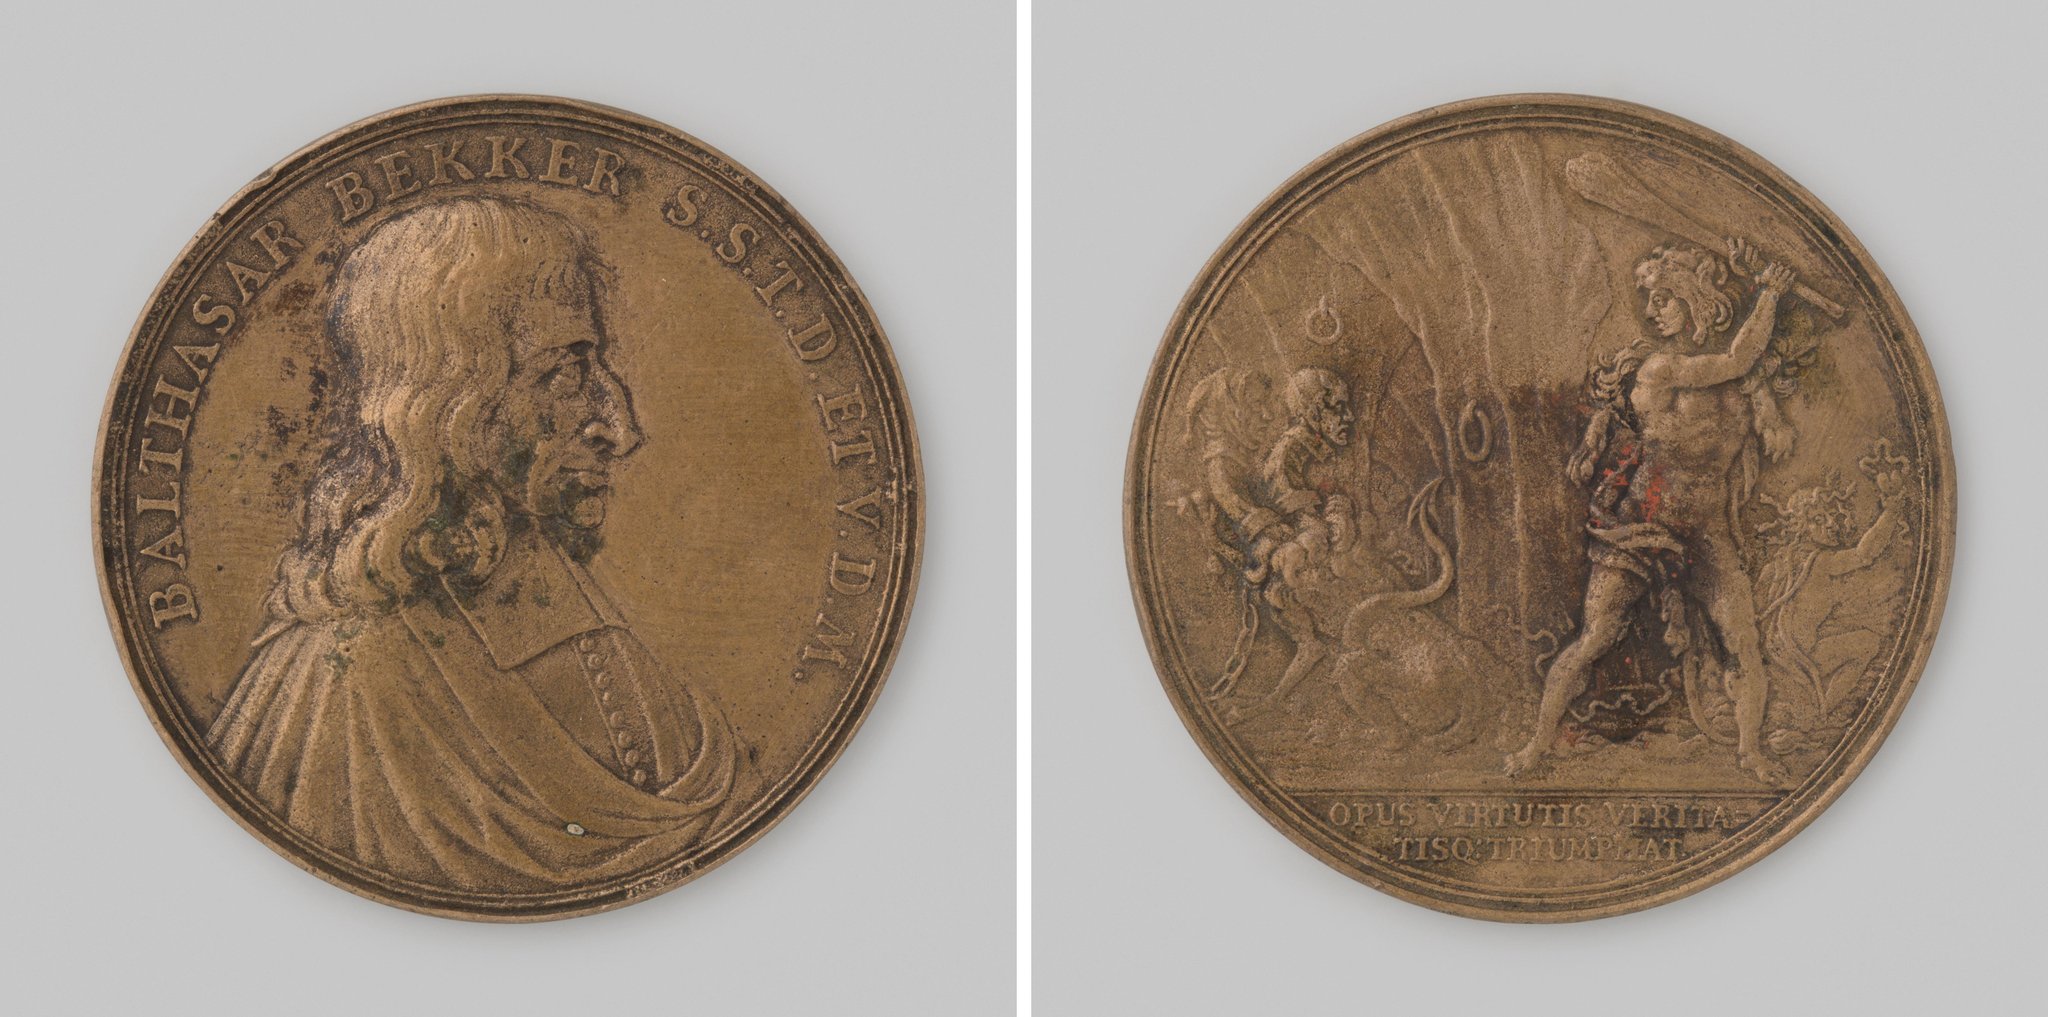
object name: history medal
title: Balthasar Becker predikant te Amsterdam 1698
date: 1698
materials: bronze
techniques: casting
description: Bronzen penning, op de voorzijde het borstbeeld van Becker naar rechts met omschrift, op de keerzijde Becker als Hercules die in een kerkergewelf een tweehoofdig monster bevecht, met afsnedetekst.